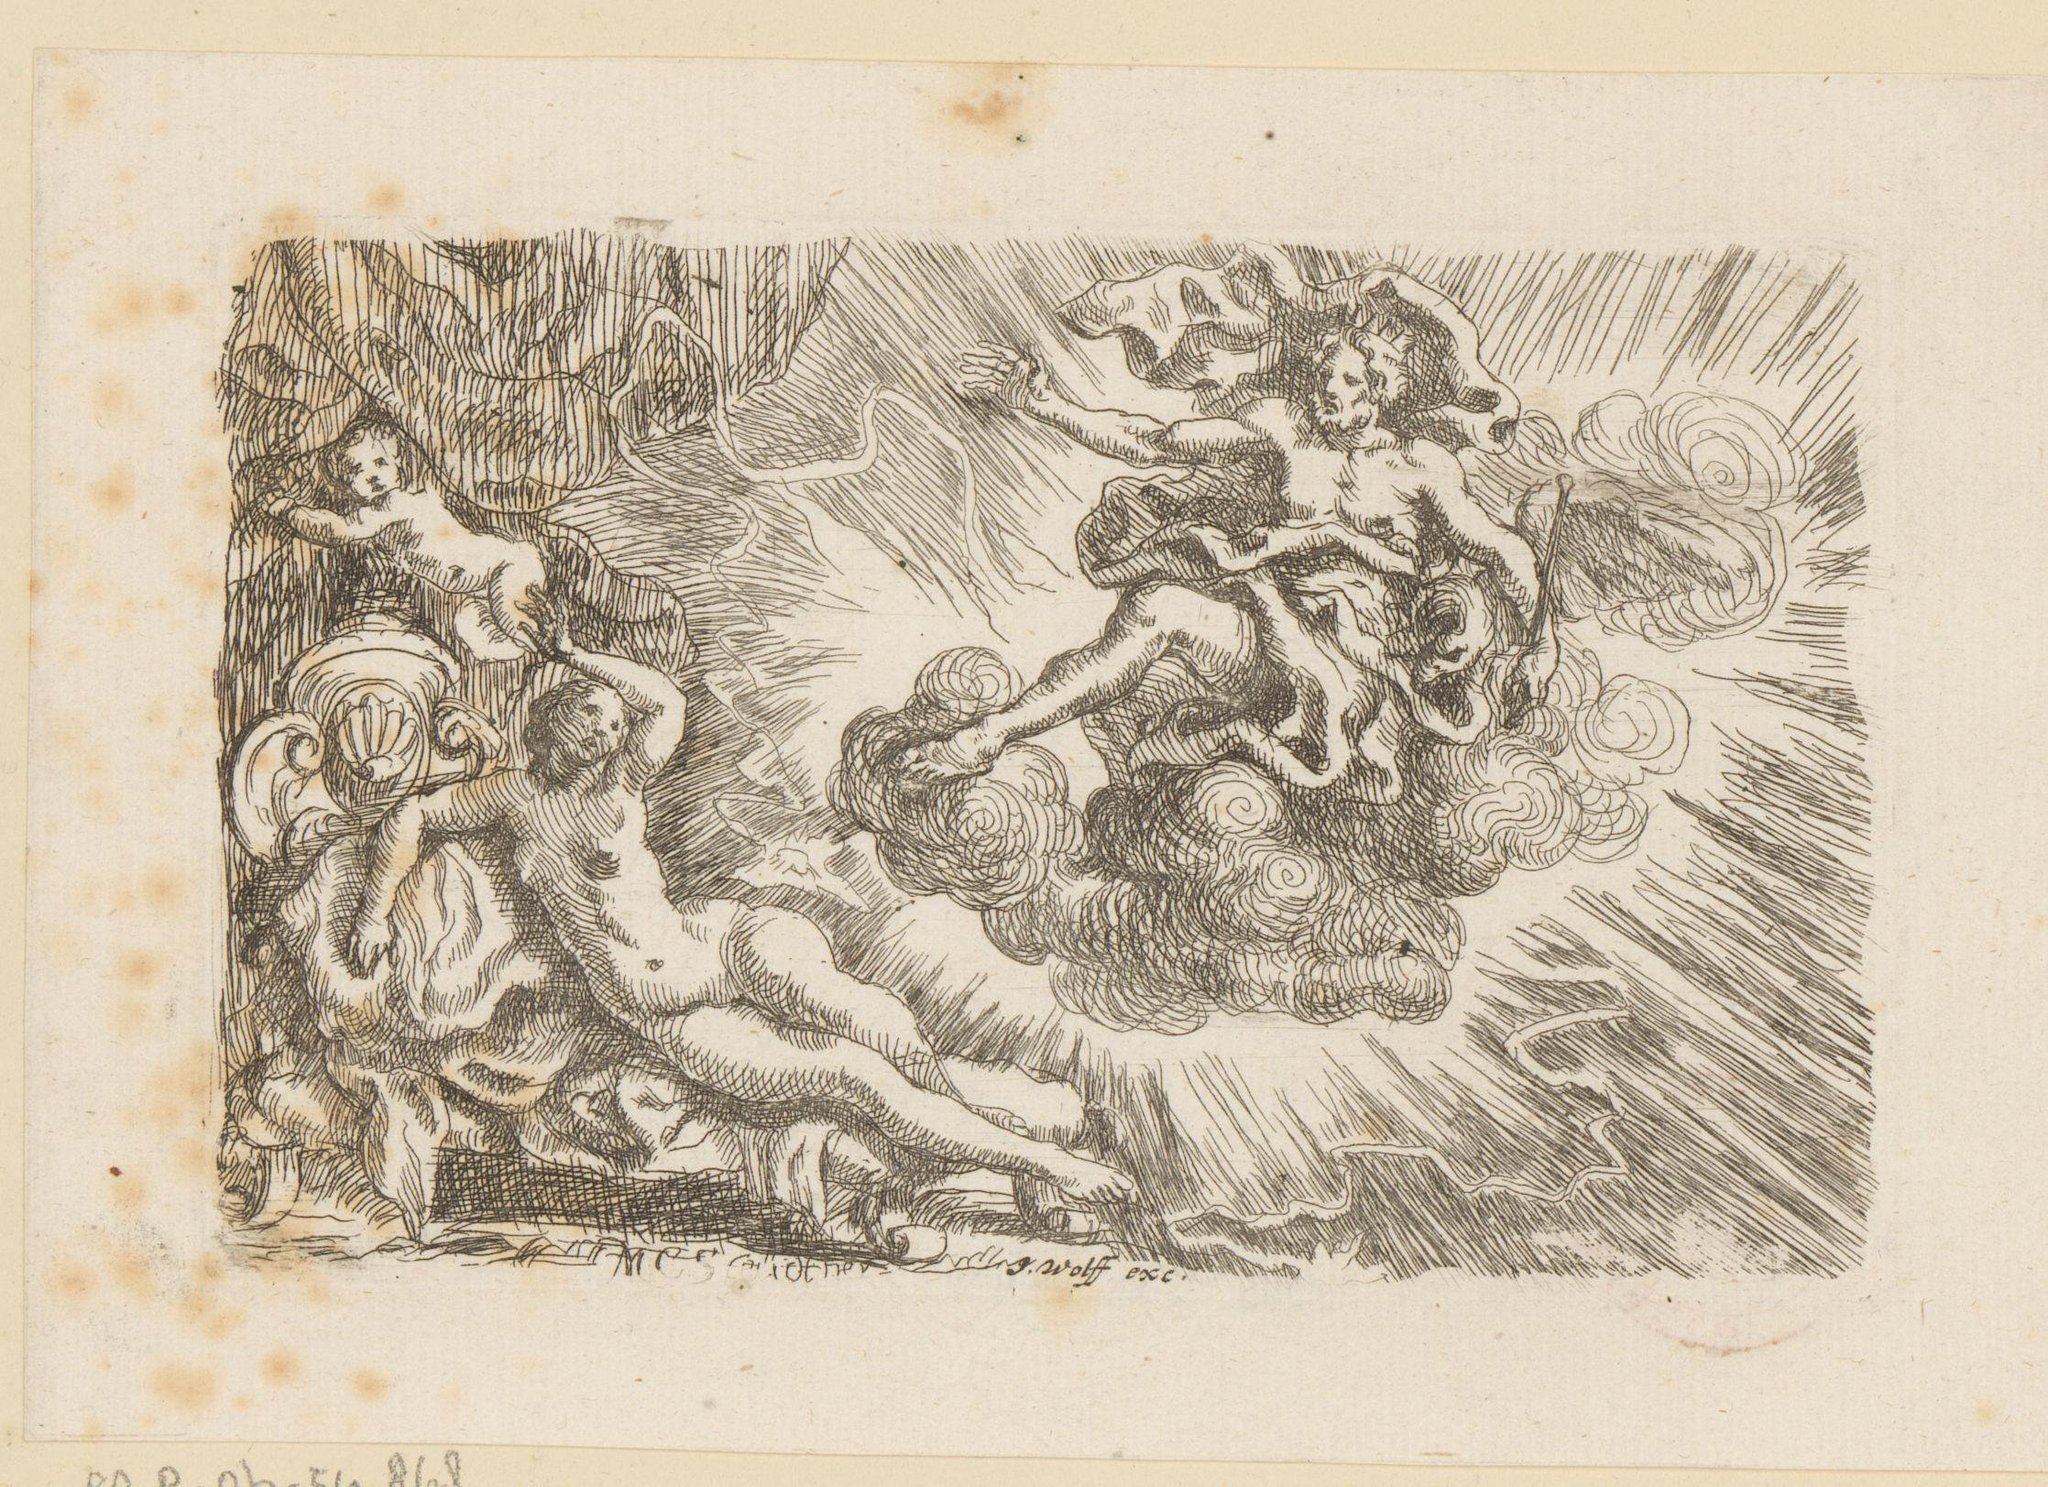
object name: print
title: Loves of the Gods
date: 1686-1704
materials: paper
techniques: etching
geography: augsburg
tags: jupiter wooing semele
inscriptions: collector's mark: Lugt 240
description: Prent maakt deel uit van een serie bestaande uit ten minste vier prenten met mythologische godenliefden.